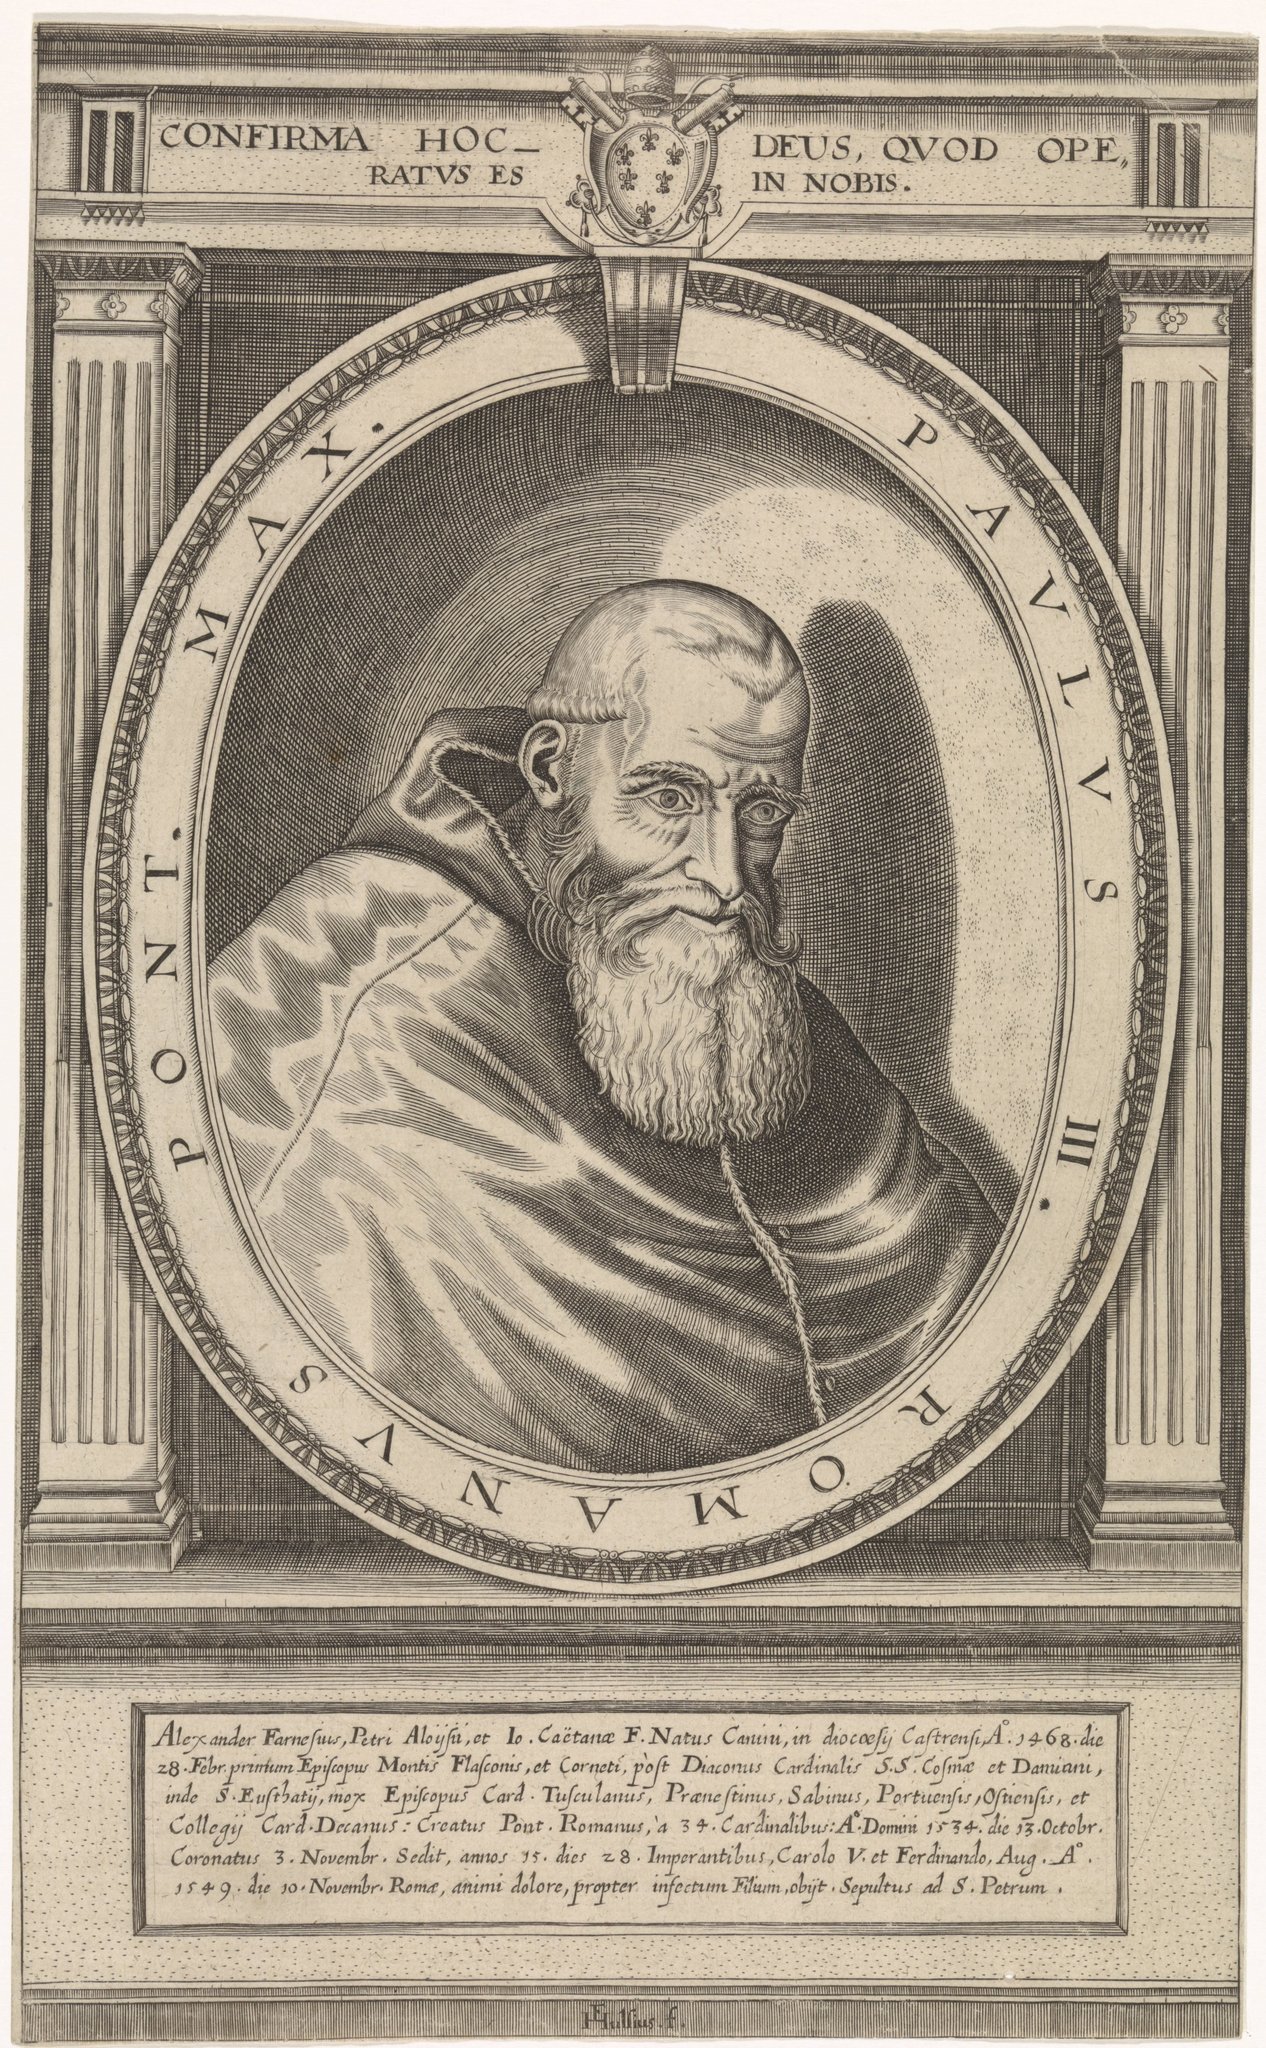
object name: print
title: Portret van paus Paulus III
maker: friedrich van hulsen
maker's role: print maker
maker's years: 1580-1660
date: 1590-1665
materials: paper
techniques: engraving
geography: germany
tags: rome, paulus iii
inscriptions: collector's mark: Lugt 2228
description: Portret van paus Paulus III gehuld in het pauselijk gewaad. Buste naar rechts in een ovale lijst met randschrift. Boven een tweeregelige tekst in het Latijn en midden boven is zijn pauselijk wapen afgebeeld. Onder het portret zes tekstregels in het Latijn.